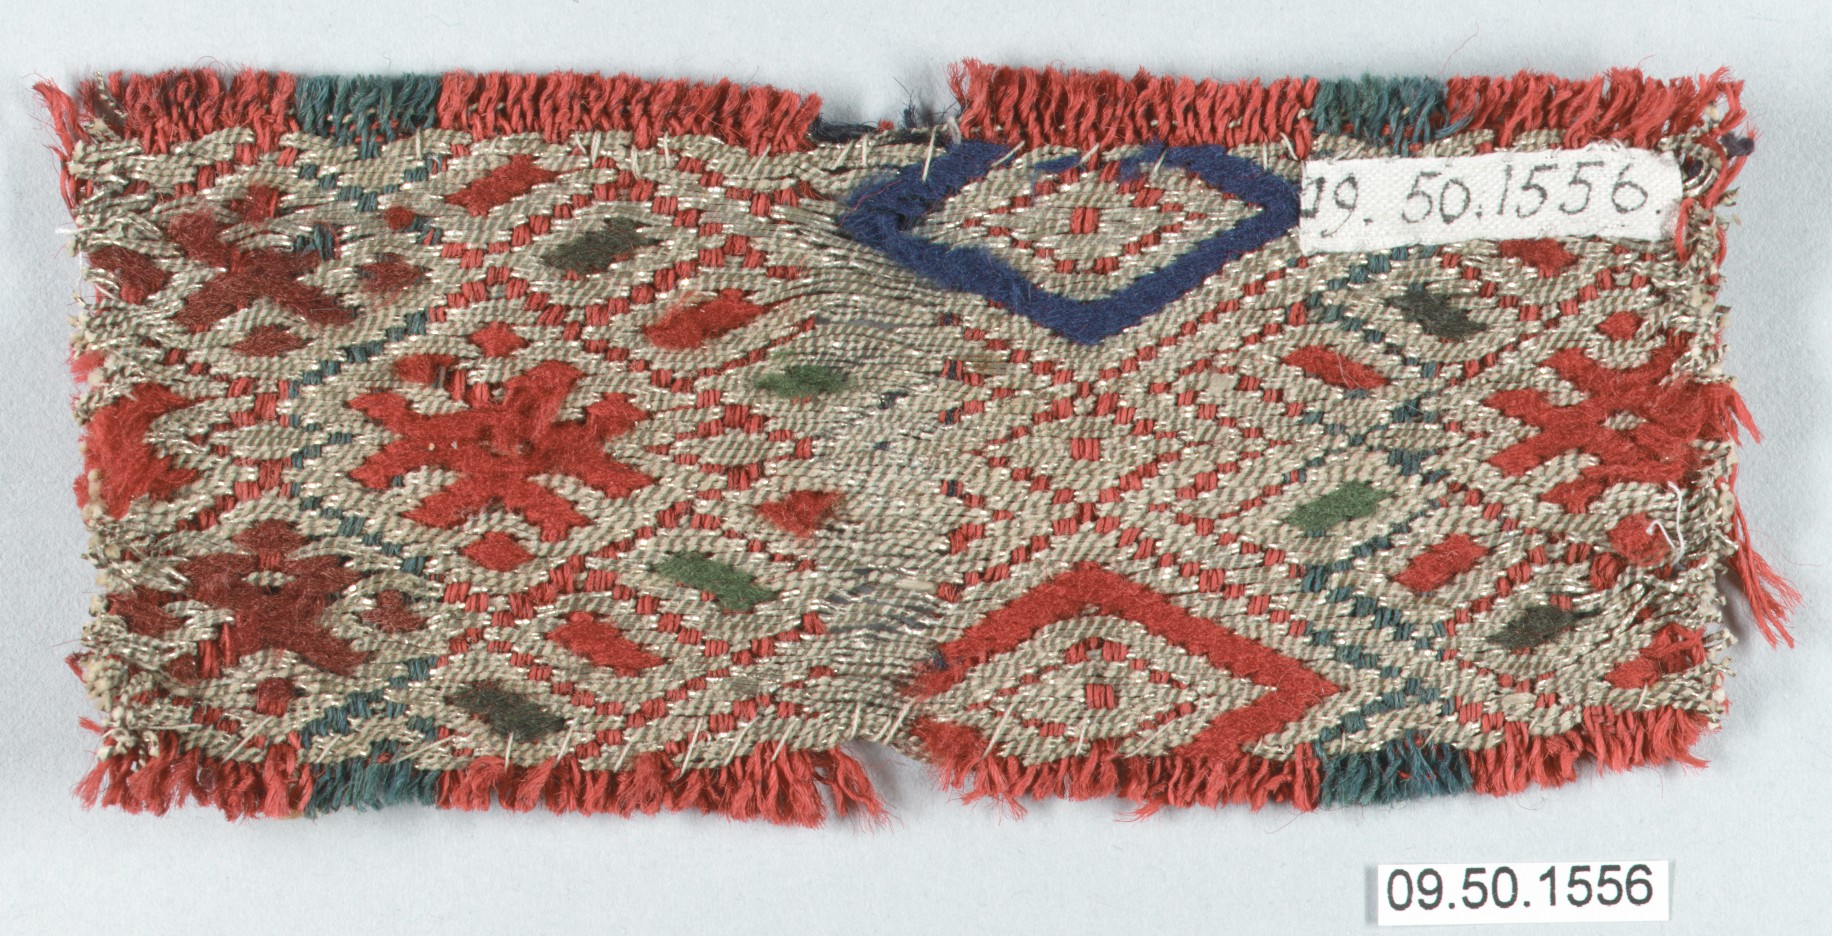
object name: fragment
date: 1801-1833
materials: metal thread